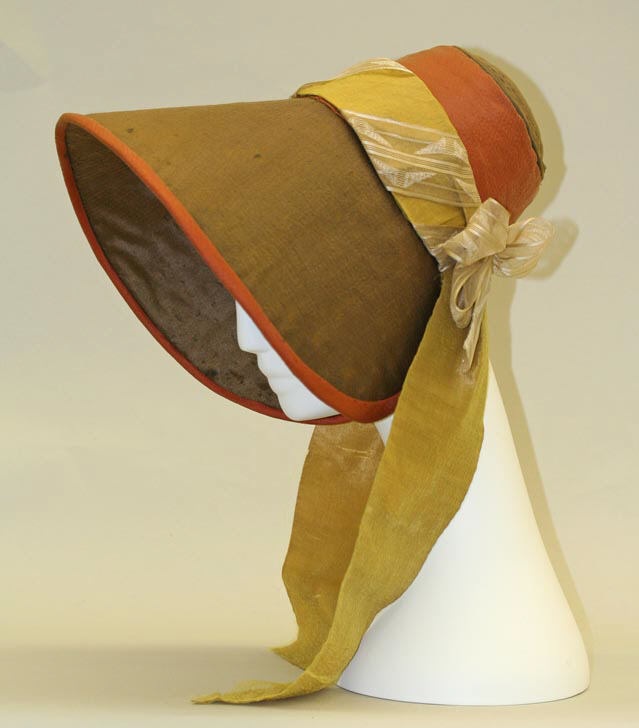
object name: poke bonnet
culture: american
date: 1830-1840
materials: silk